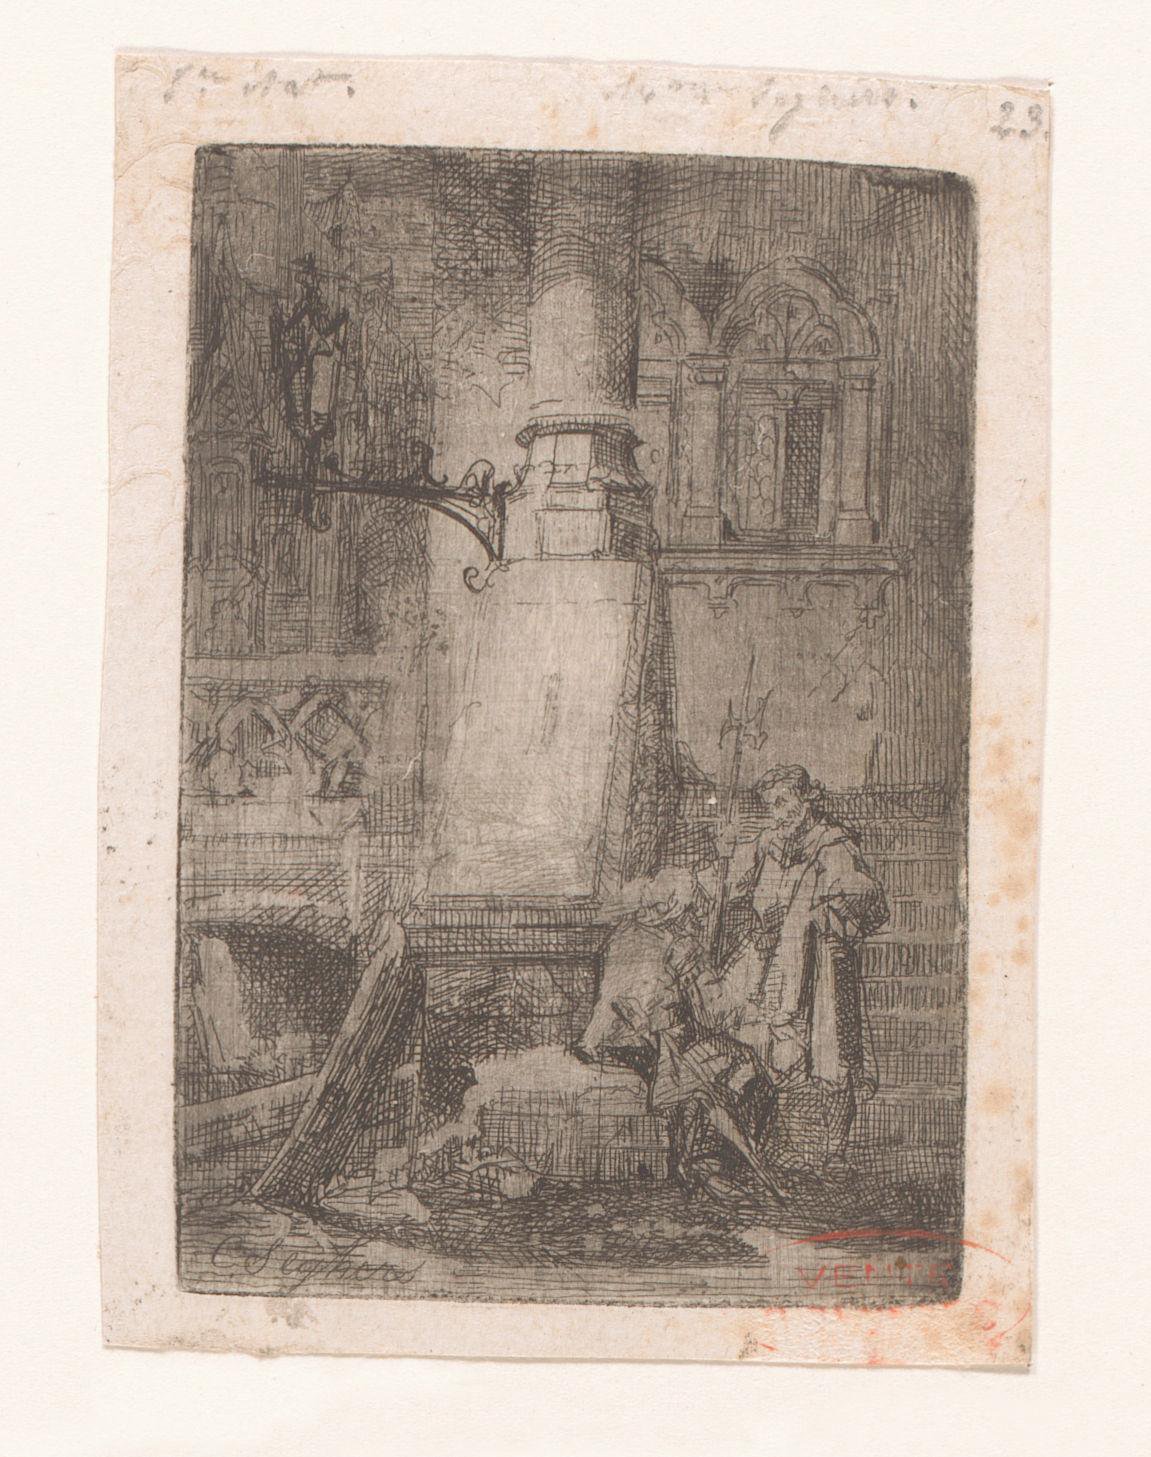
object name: print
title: Twee soldaten aan de voet van een trap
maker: corneille seghers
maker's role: draughtsman, print maker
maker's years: 1814-1869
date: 1824-1869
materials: paper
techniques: aquatint, drypoint, etching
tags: stairwell, private soldier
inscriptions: collector's mark: Lugt 2228